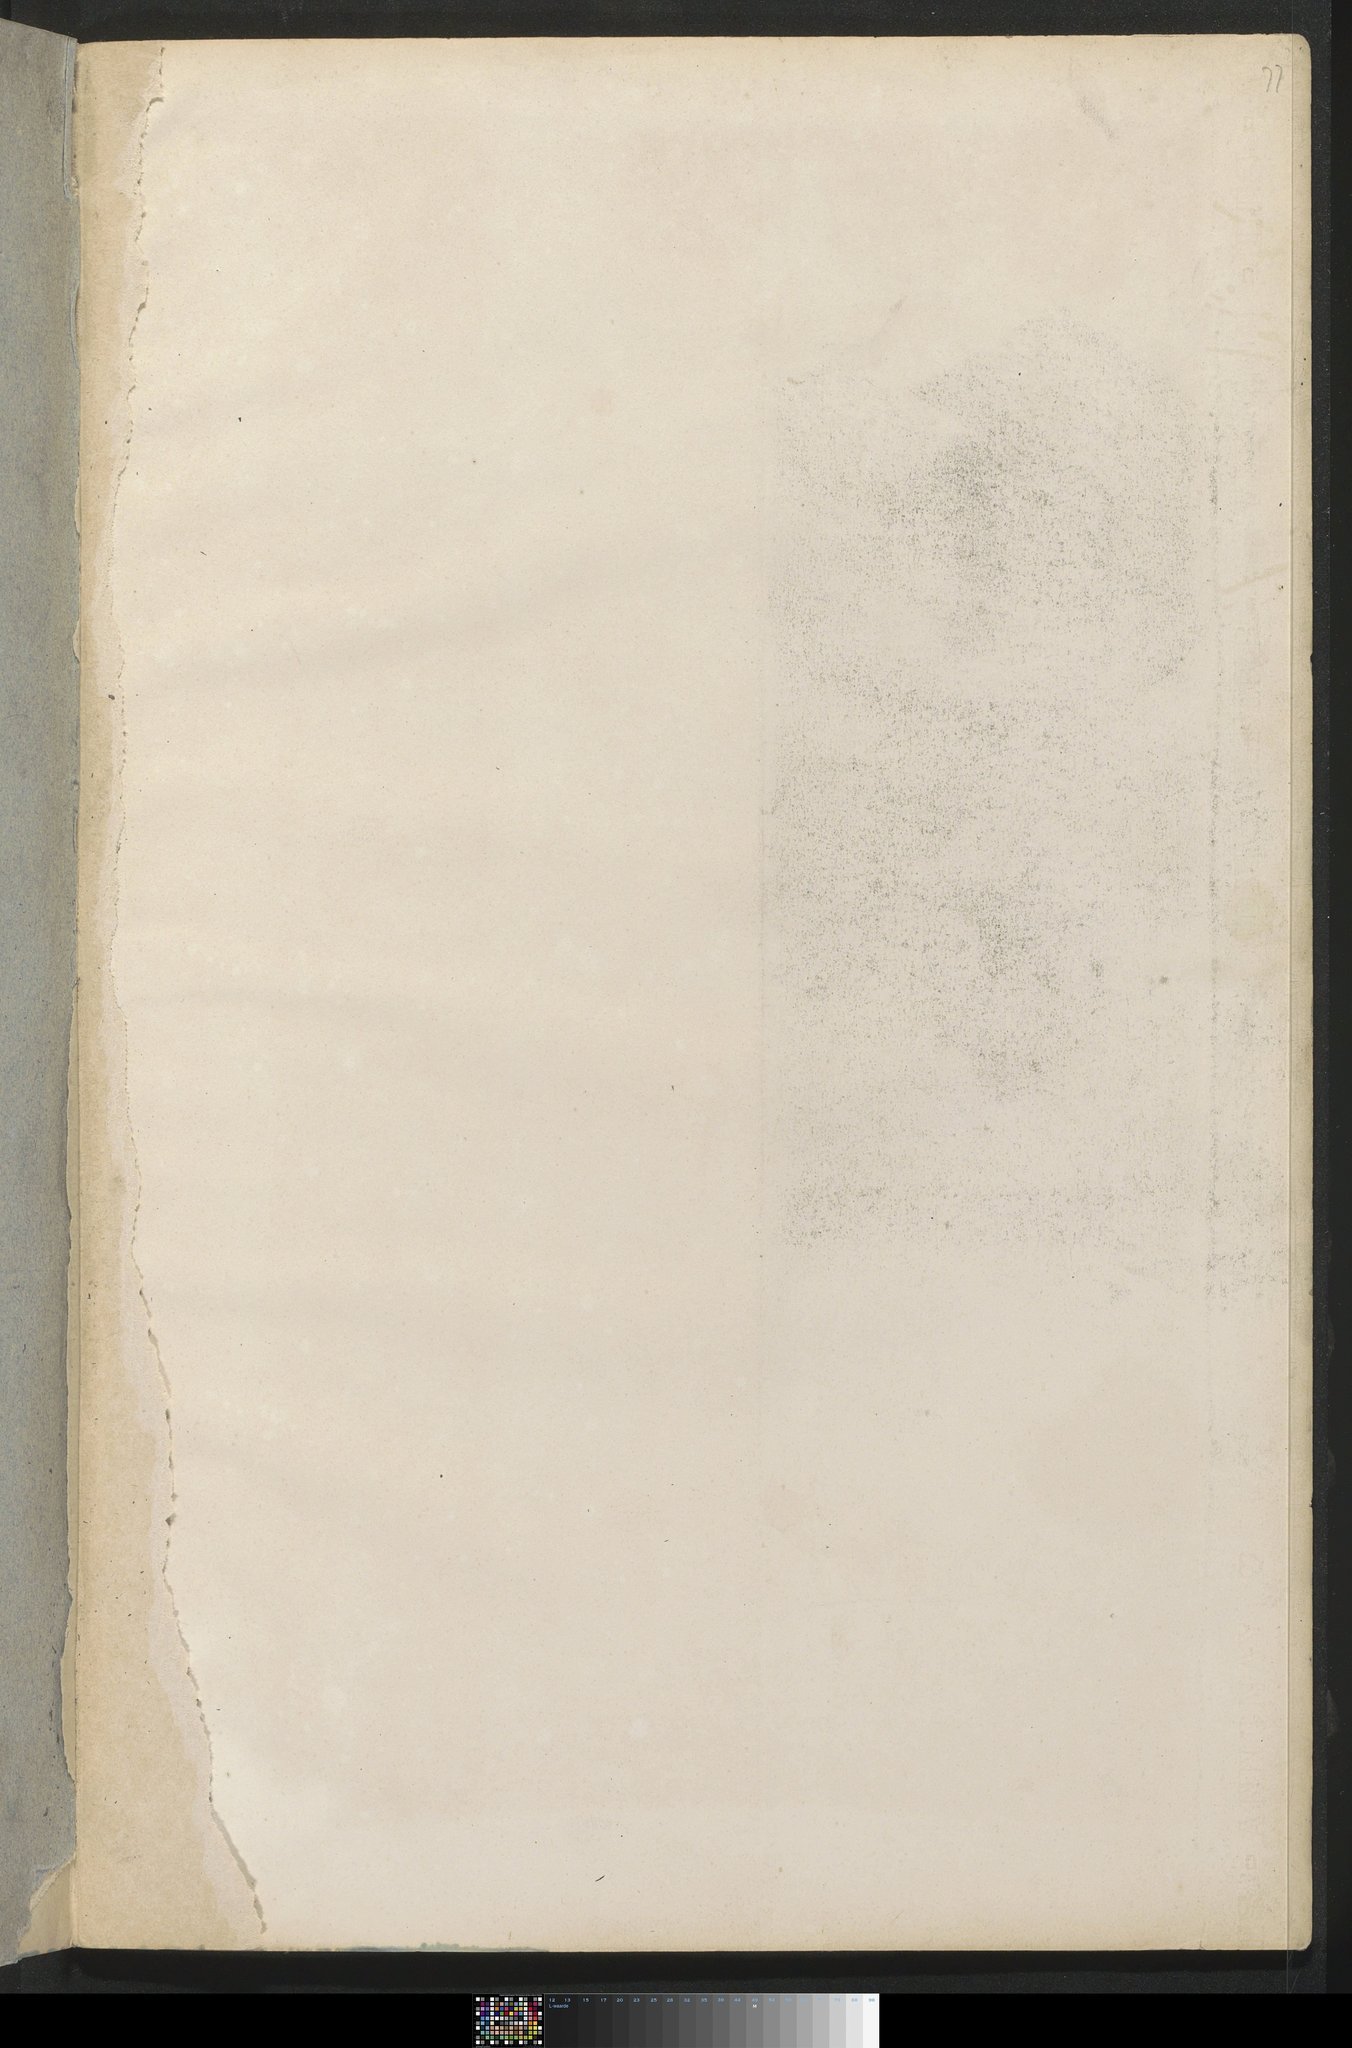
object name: sketchbook leaf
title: Abklatsch van een krijttekening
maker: willem witsen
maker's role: draughtsman, painter, print maker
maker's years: 1860-1923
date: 1884-1887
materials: paper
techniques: printmaking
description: Pagina 77 uit een schetsboek met 38 bladen.